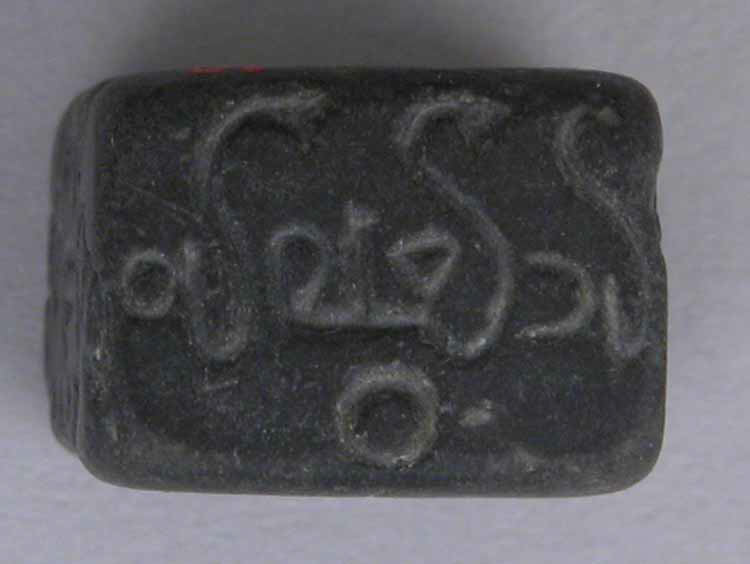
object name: seal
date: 1001-1200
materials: stone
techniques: carving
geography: iran